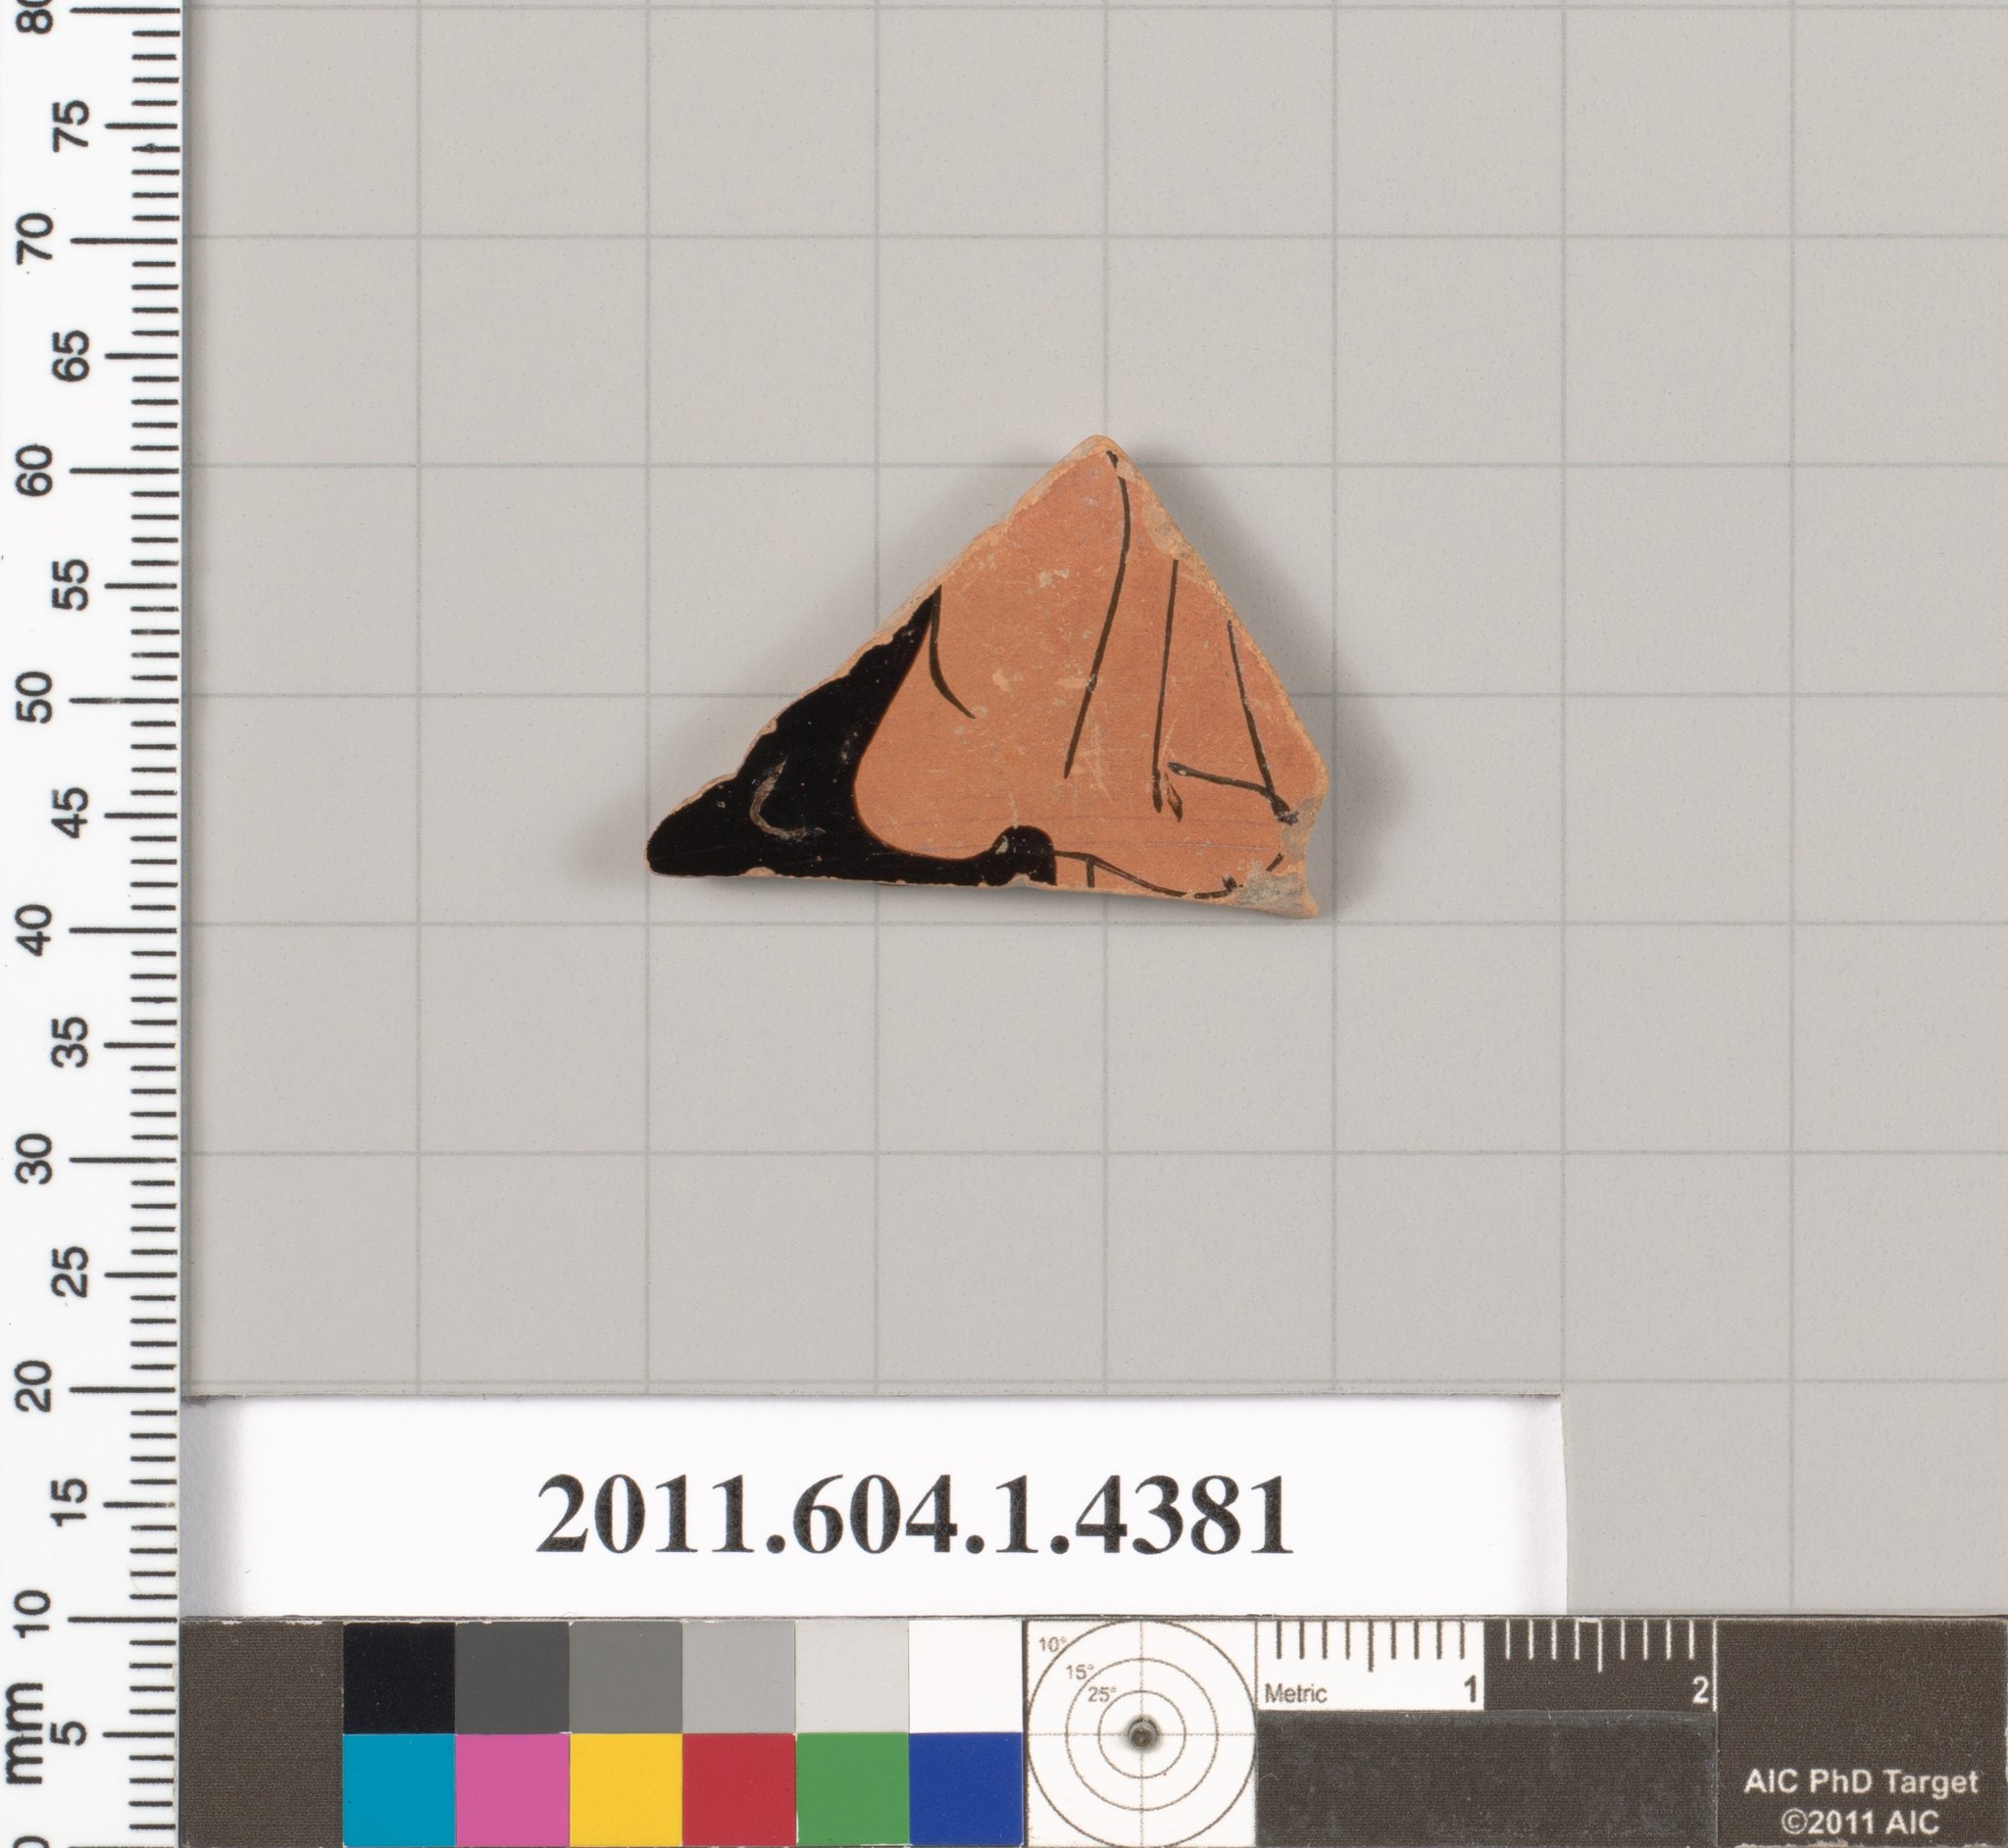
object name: kylix fragment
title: Terracotta fragment of a kylix (drinking cup)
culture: greek, attic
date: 475-451 BCE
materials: terracotta